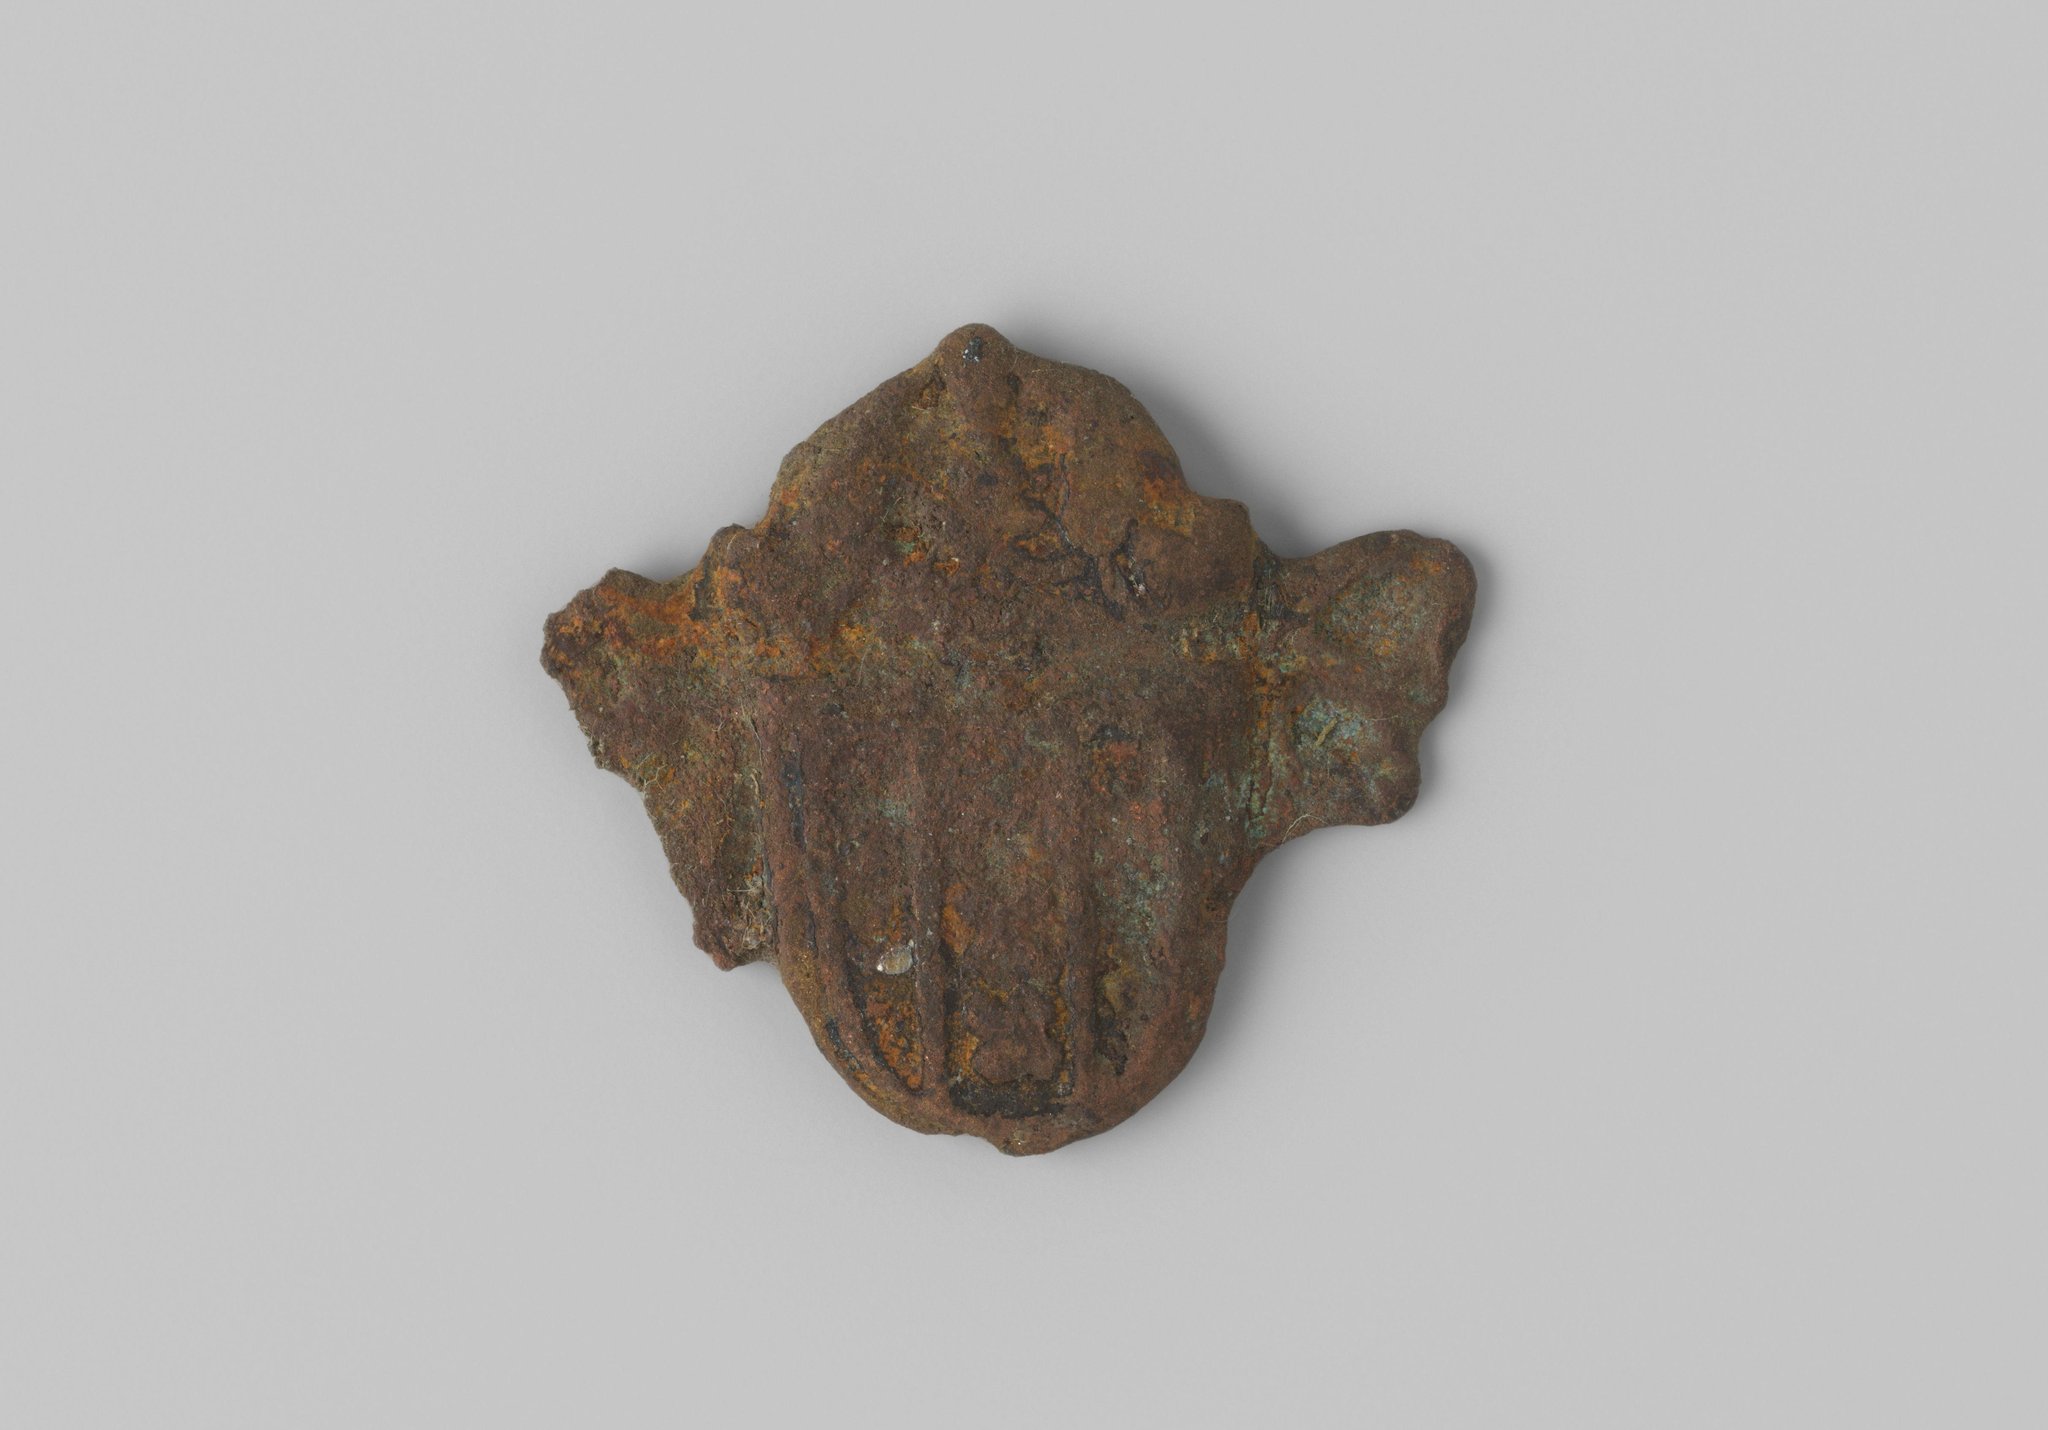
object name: schroefplaat, schroefblik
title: Fragment schroefplaat van een musket uit het wrak van de Oost-Indiëvaarder Hollandia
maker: Anonymous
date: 1700-1743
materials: copper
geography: netherlands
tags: verenigde oostindische compagnie, hollandia (schip), annet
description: Fragm, id. NG 1978-74H986 or NG 1980-27H3069, wings broken off, side plate.